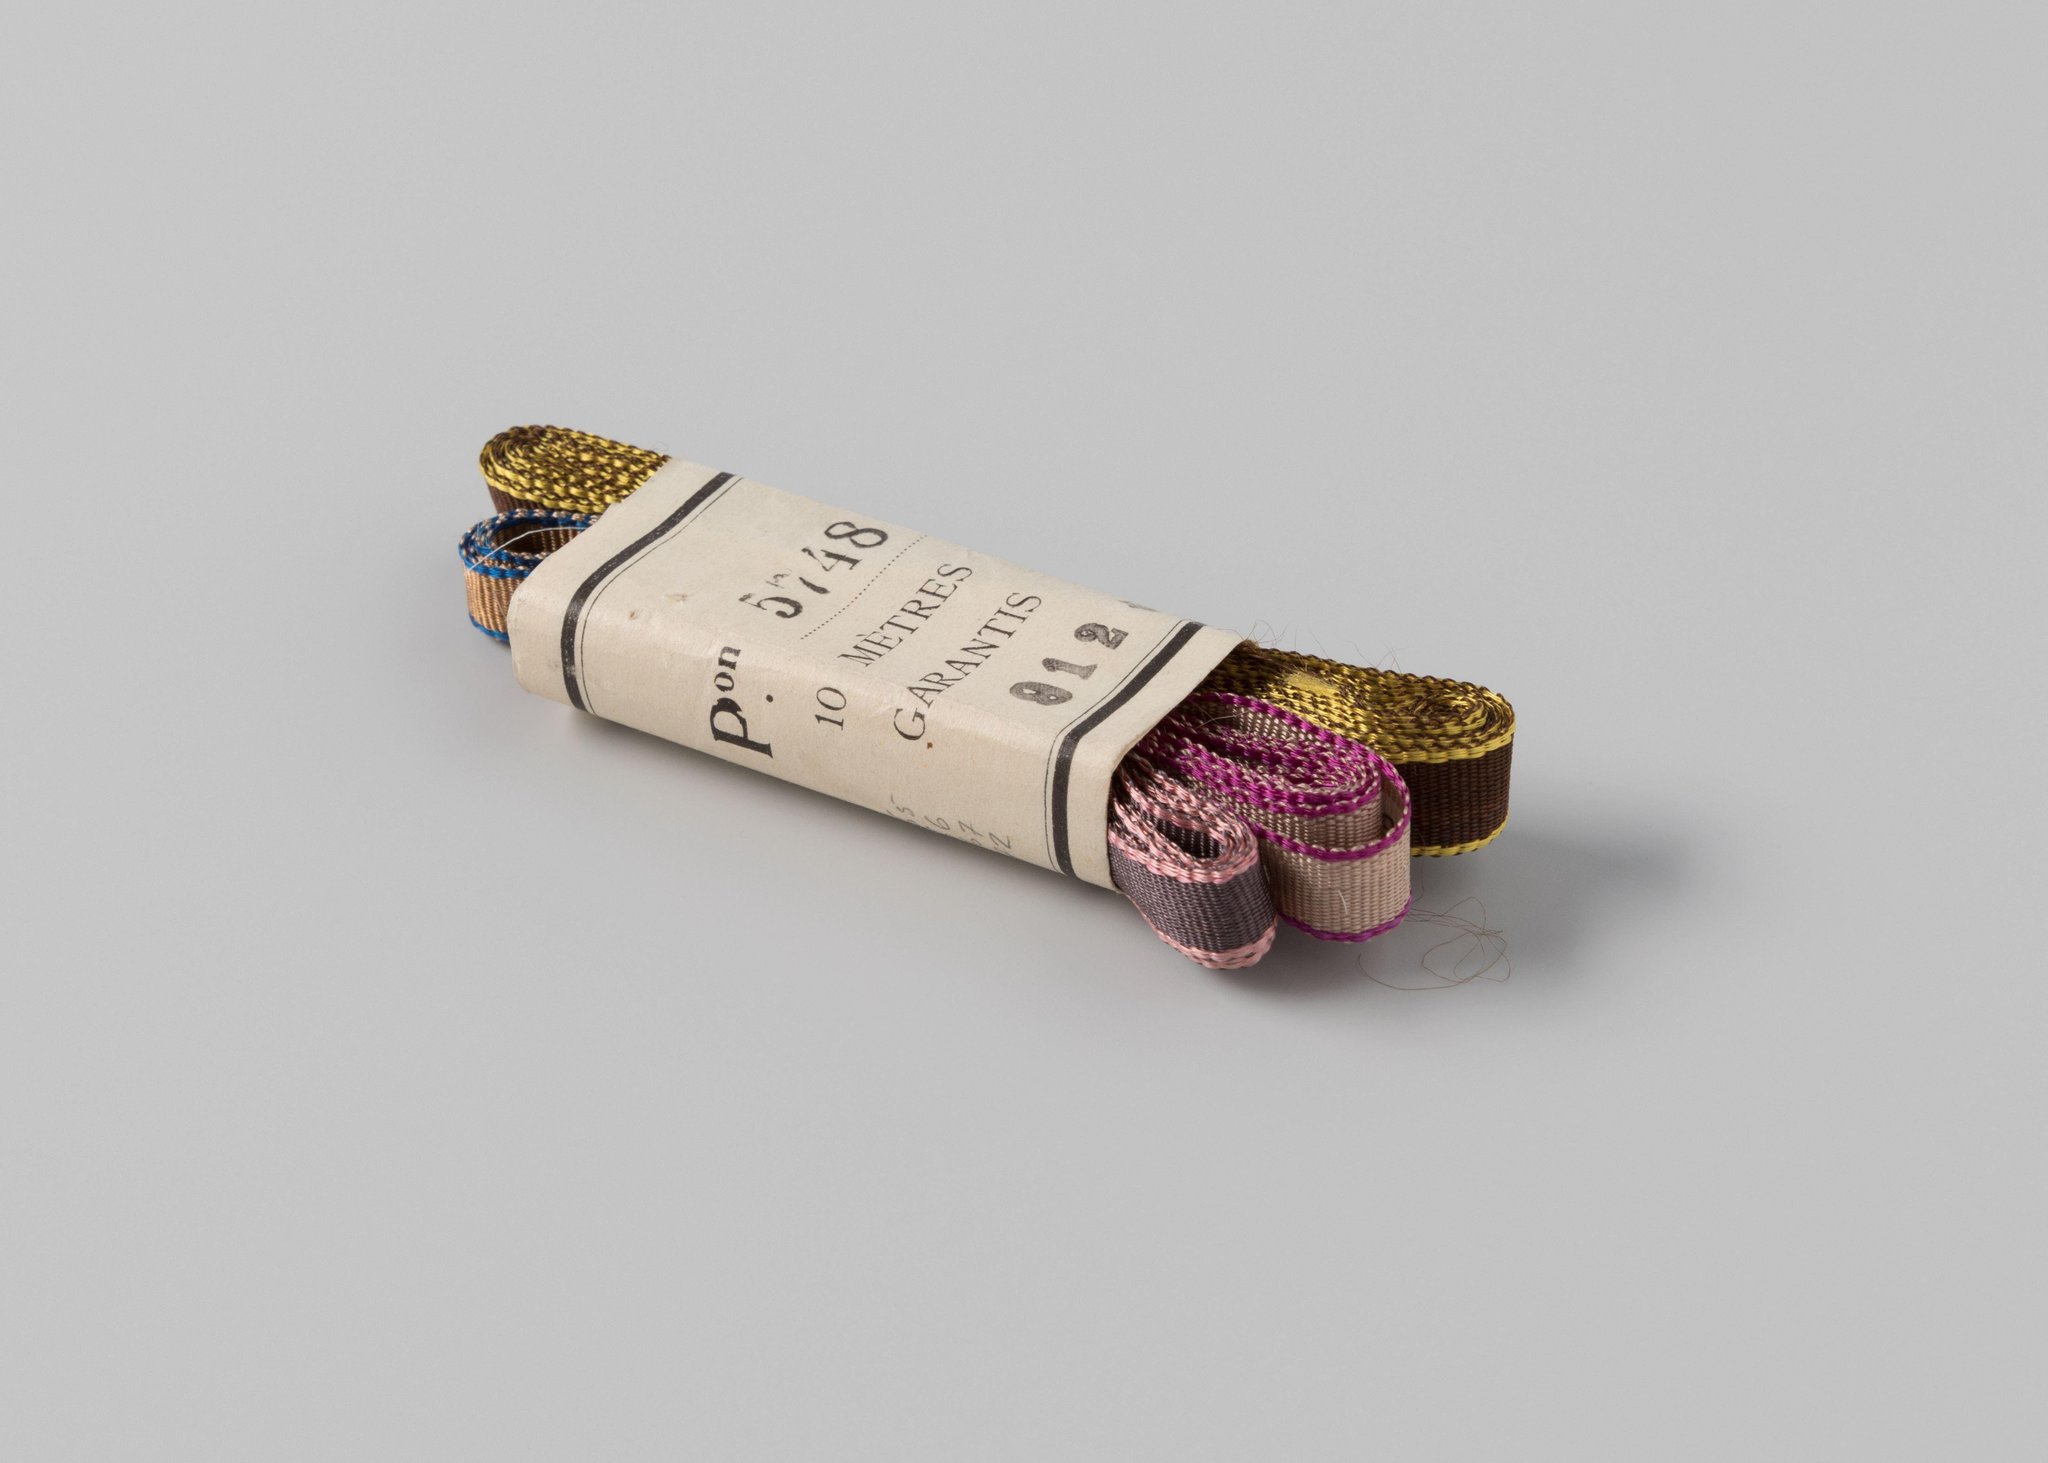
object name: braid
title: Lint, geel, aan beide zijden blauw afgebiesd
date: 1890-1935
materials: textile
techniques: weave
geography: france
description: Lint, geel, aan beide zijden blauw afgebiesd.